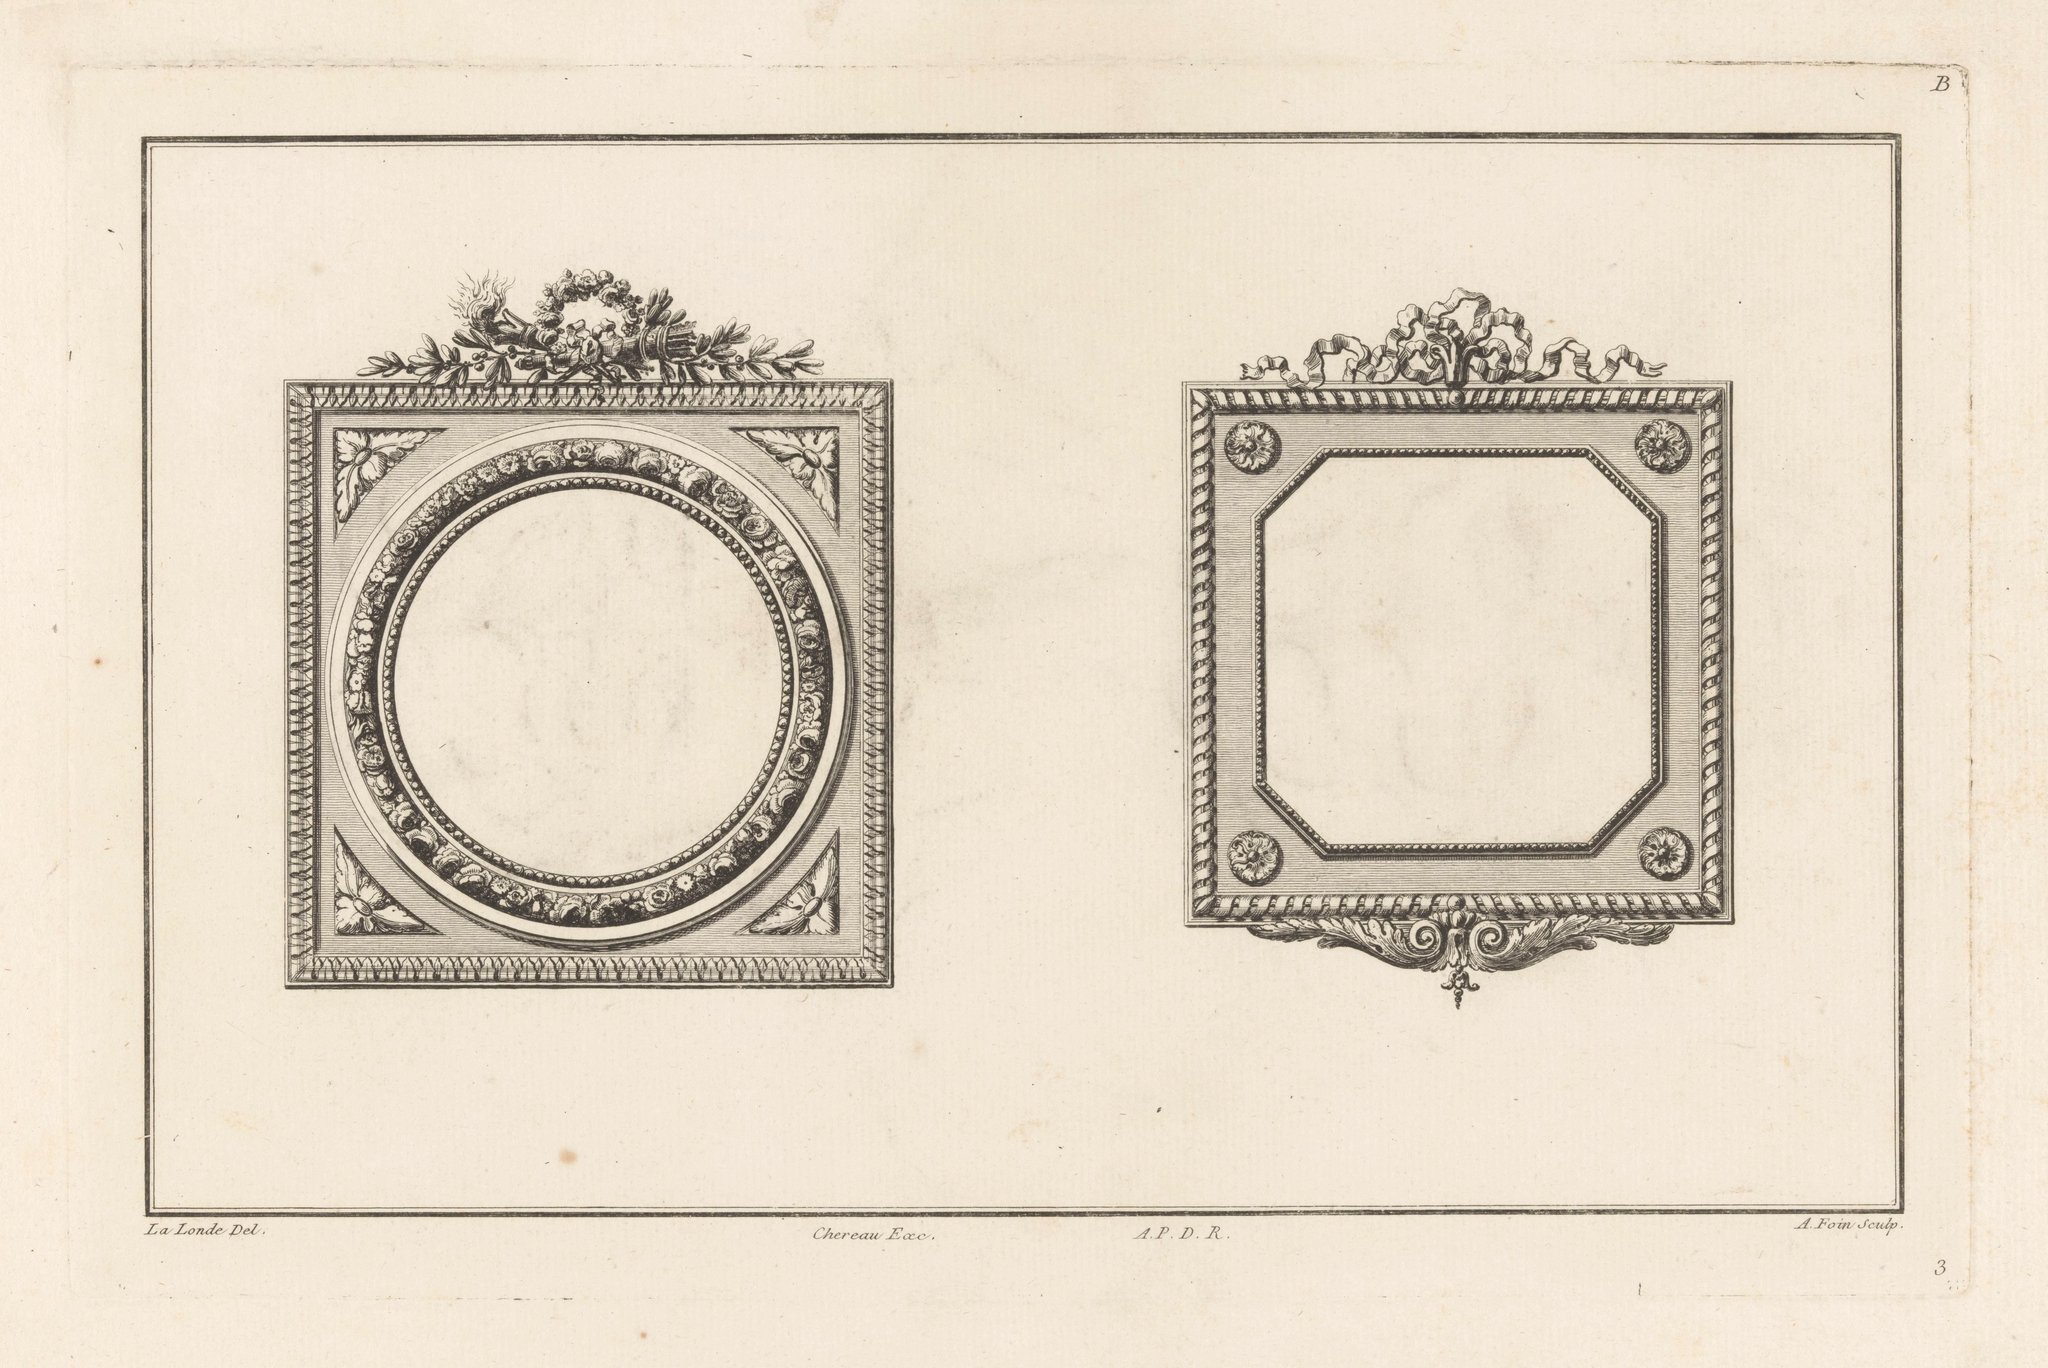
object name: print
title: Twee vierkante omlijstingen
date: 1784-1785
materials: paper, pencil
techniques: engraving, etching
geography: paris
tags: ornaments ~ art (+ framing decorations)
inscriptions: collector's mark: Lugt 2760, collector's mark: Lugt 2228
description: Links een vierkante omlijsting met krans, fakkels en ronde binnenzijde. Rechts een vierkante omlijsting met linten en achthoekige binnenzijde. Verso tekening van een gezicht.